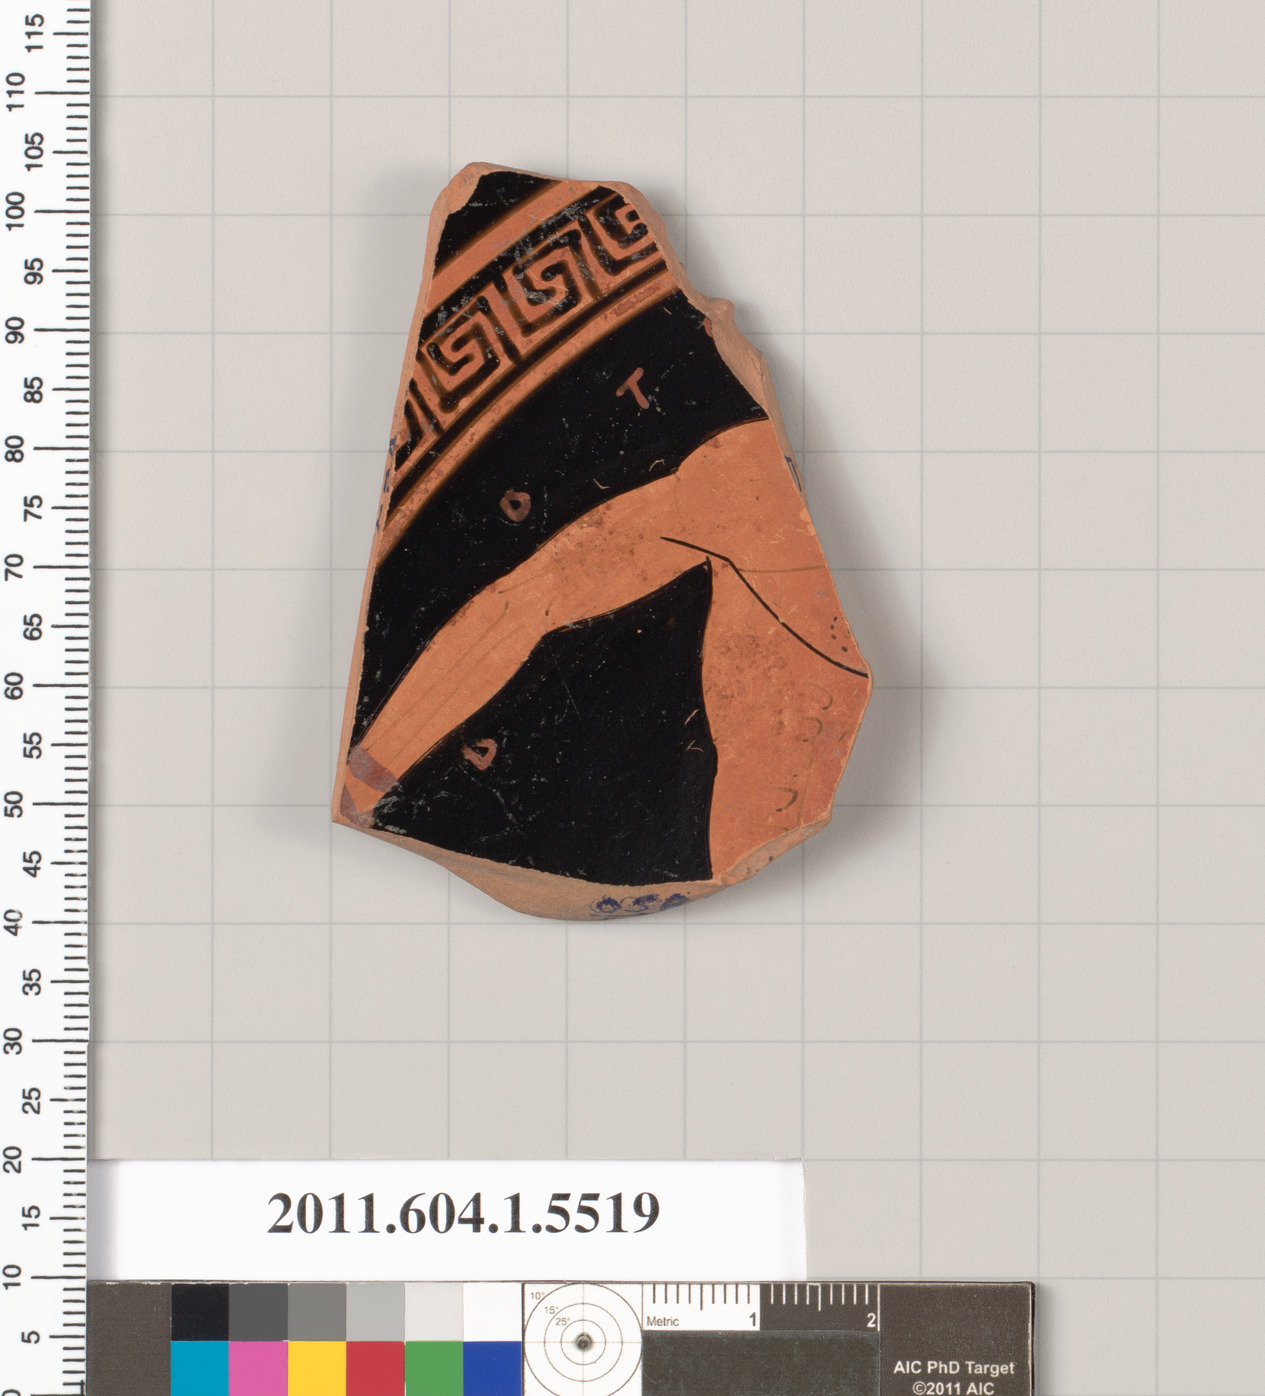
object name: kylix fragment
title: Terracotta fragment of a kylix (drinking cup)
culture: greek, attic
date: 510-490 BCE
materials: terracotta